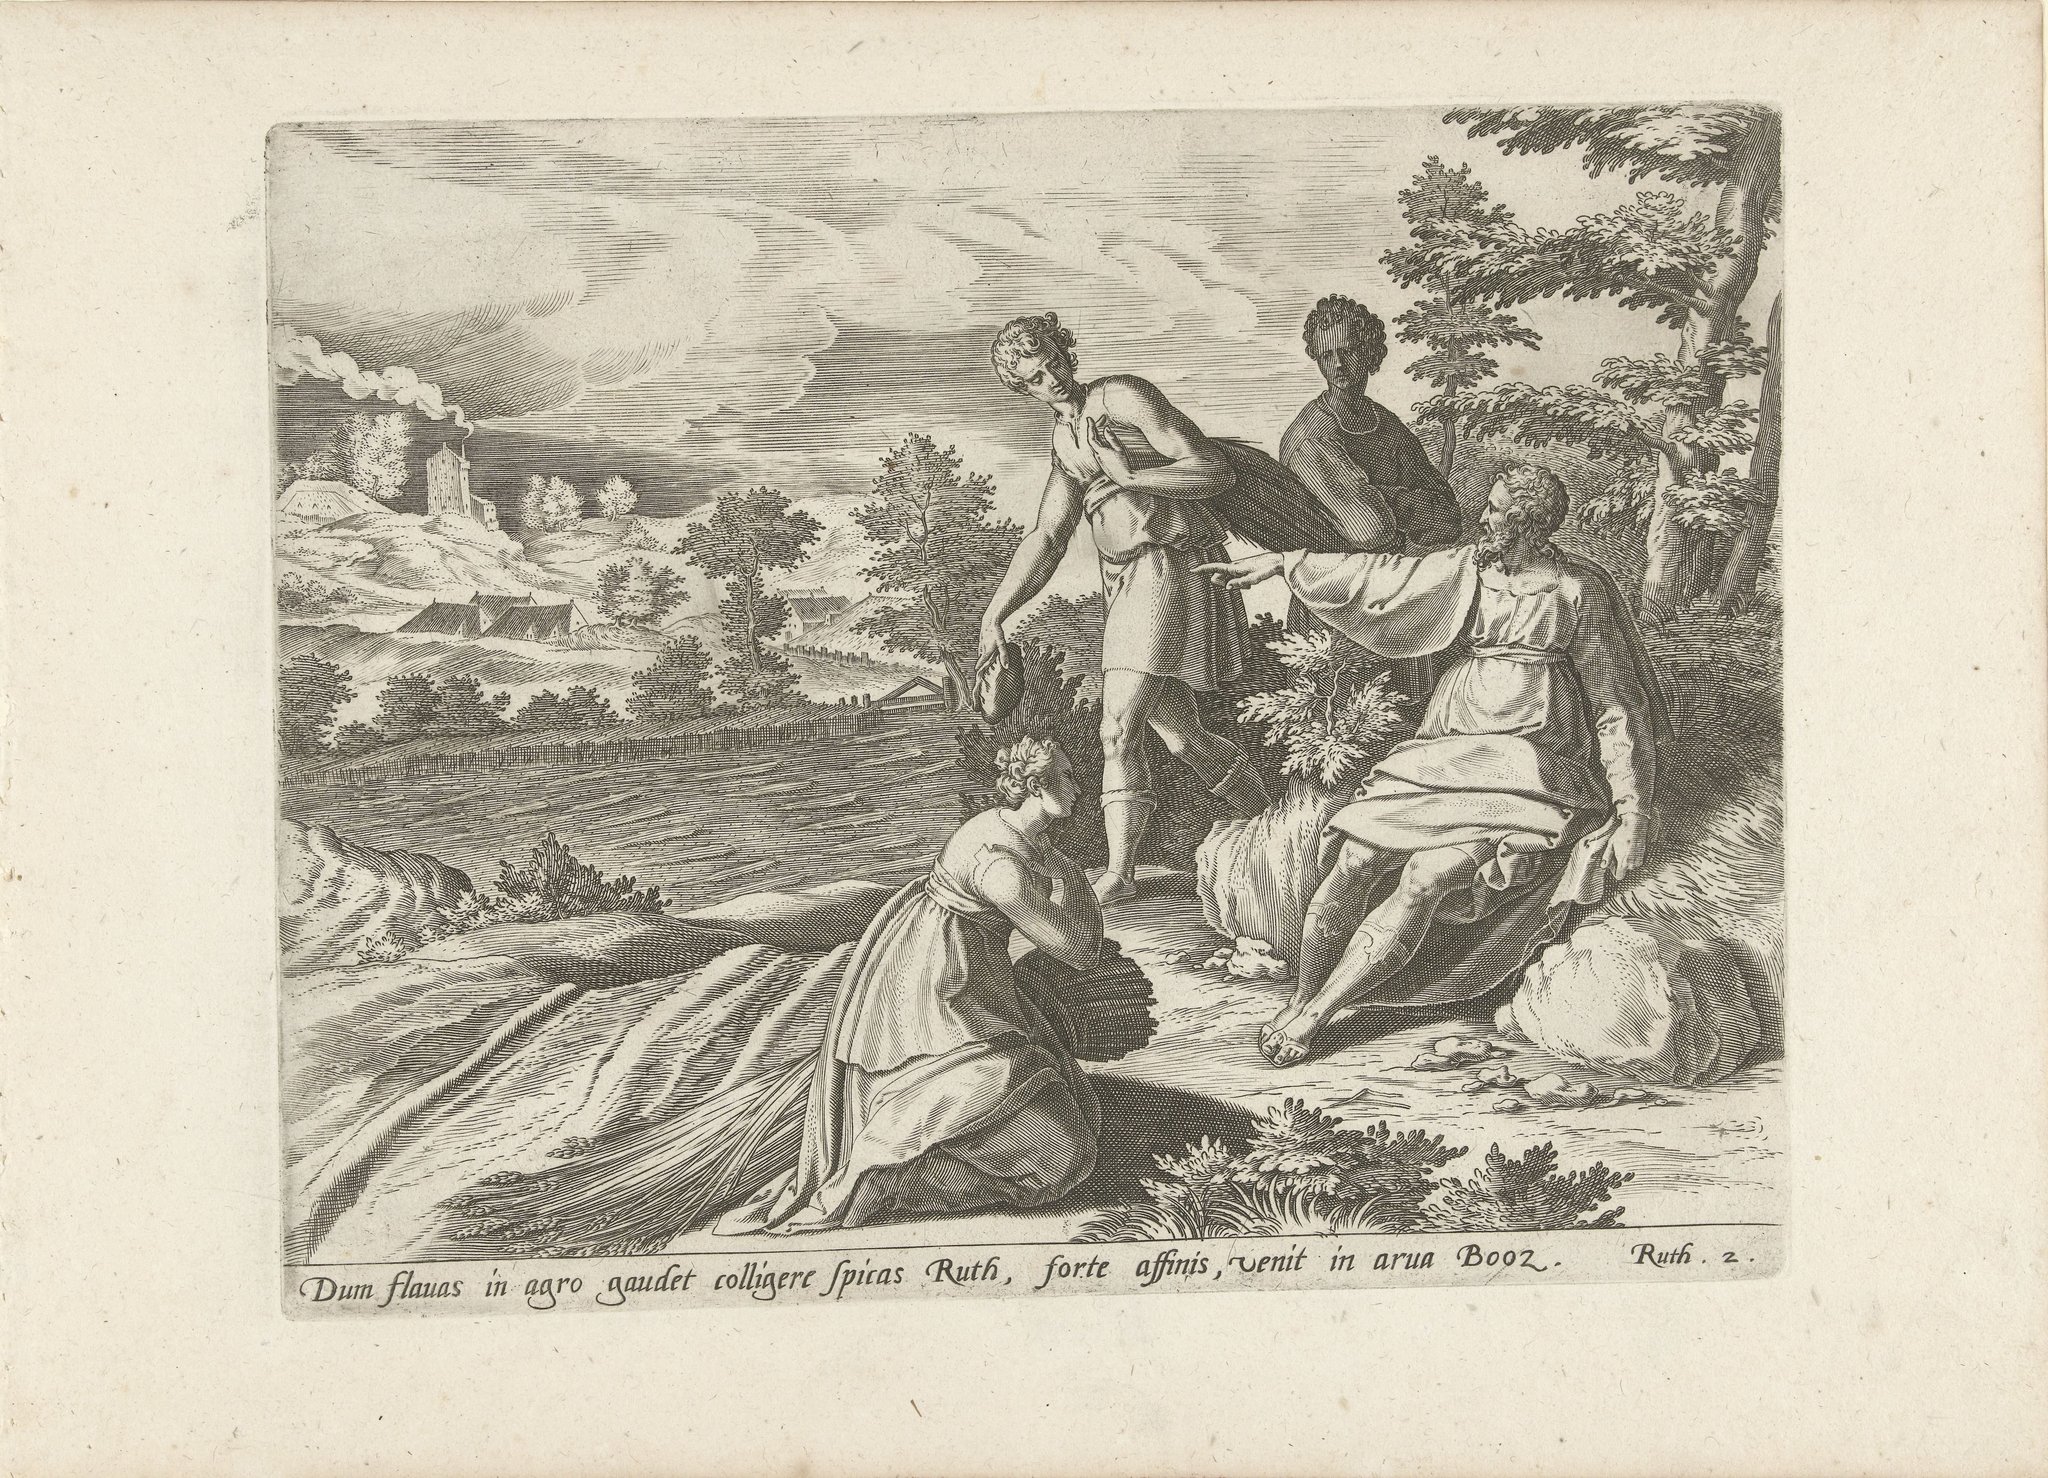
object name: print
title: Geschiedenis van Ruth en Boaz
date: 1557-1591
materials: paper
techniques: engraving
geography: antwerp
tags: boaz speaks to ruth; ruth usually bowing down, or kneeling before him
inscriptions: collector's mark: Lugt 2760, collector's mark: Lugt 2228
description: Boaz spreekt met Ruth, die op zijn akker aren heeft geraapt. Ruth knielt voor hem met een bundel aren onder de arm. Boaz wijst op zijn akker en zegt dat ze aren mag blijven rapen. Onder de voorstelling een verwijzing in het Latijn naar de Bijbeltekst in Ruth 2.